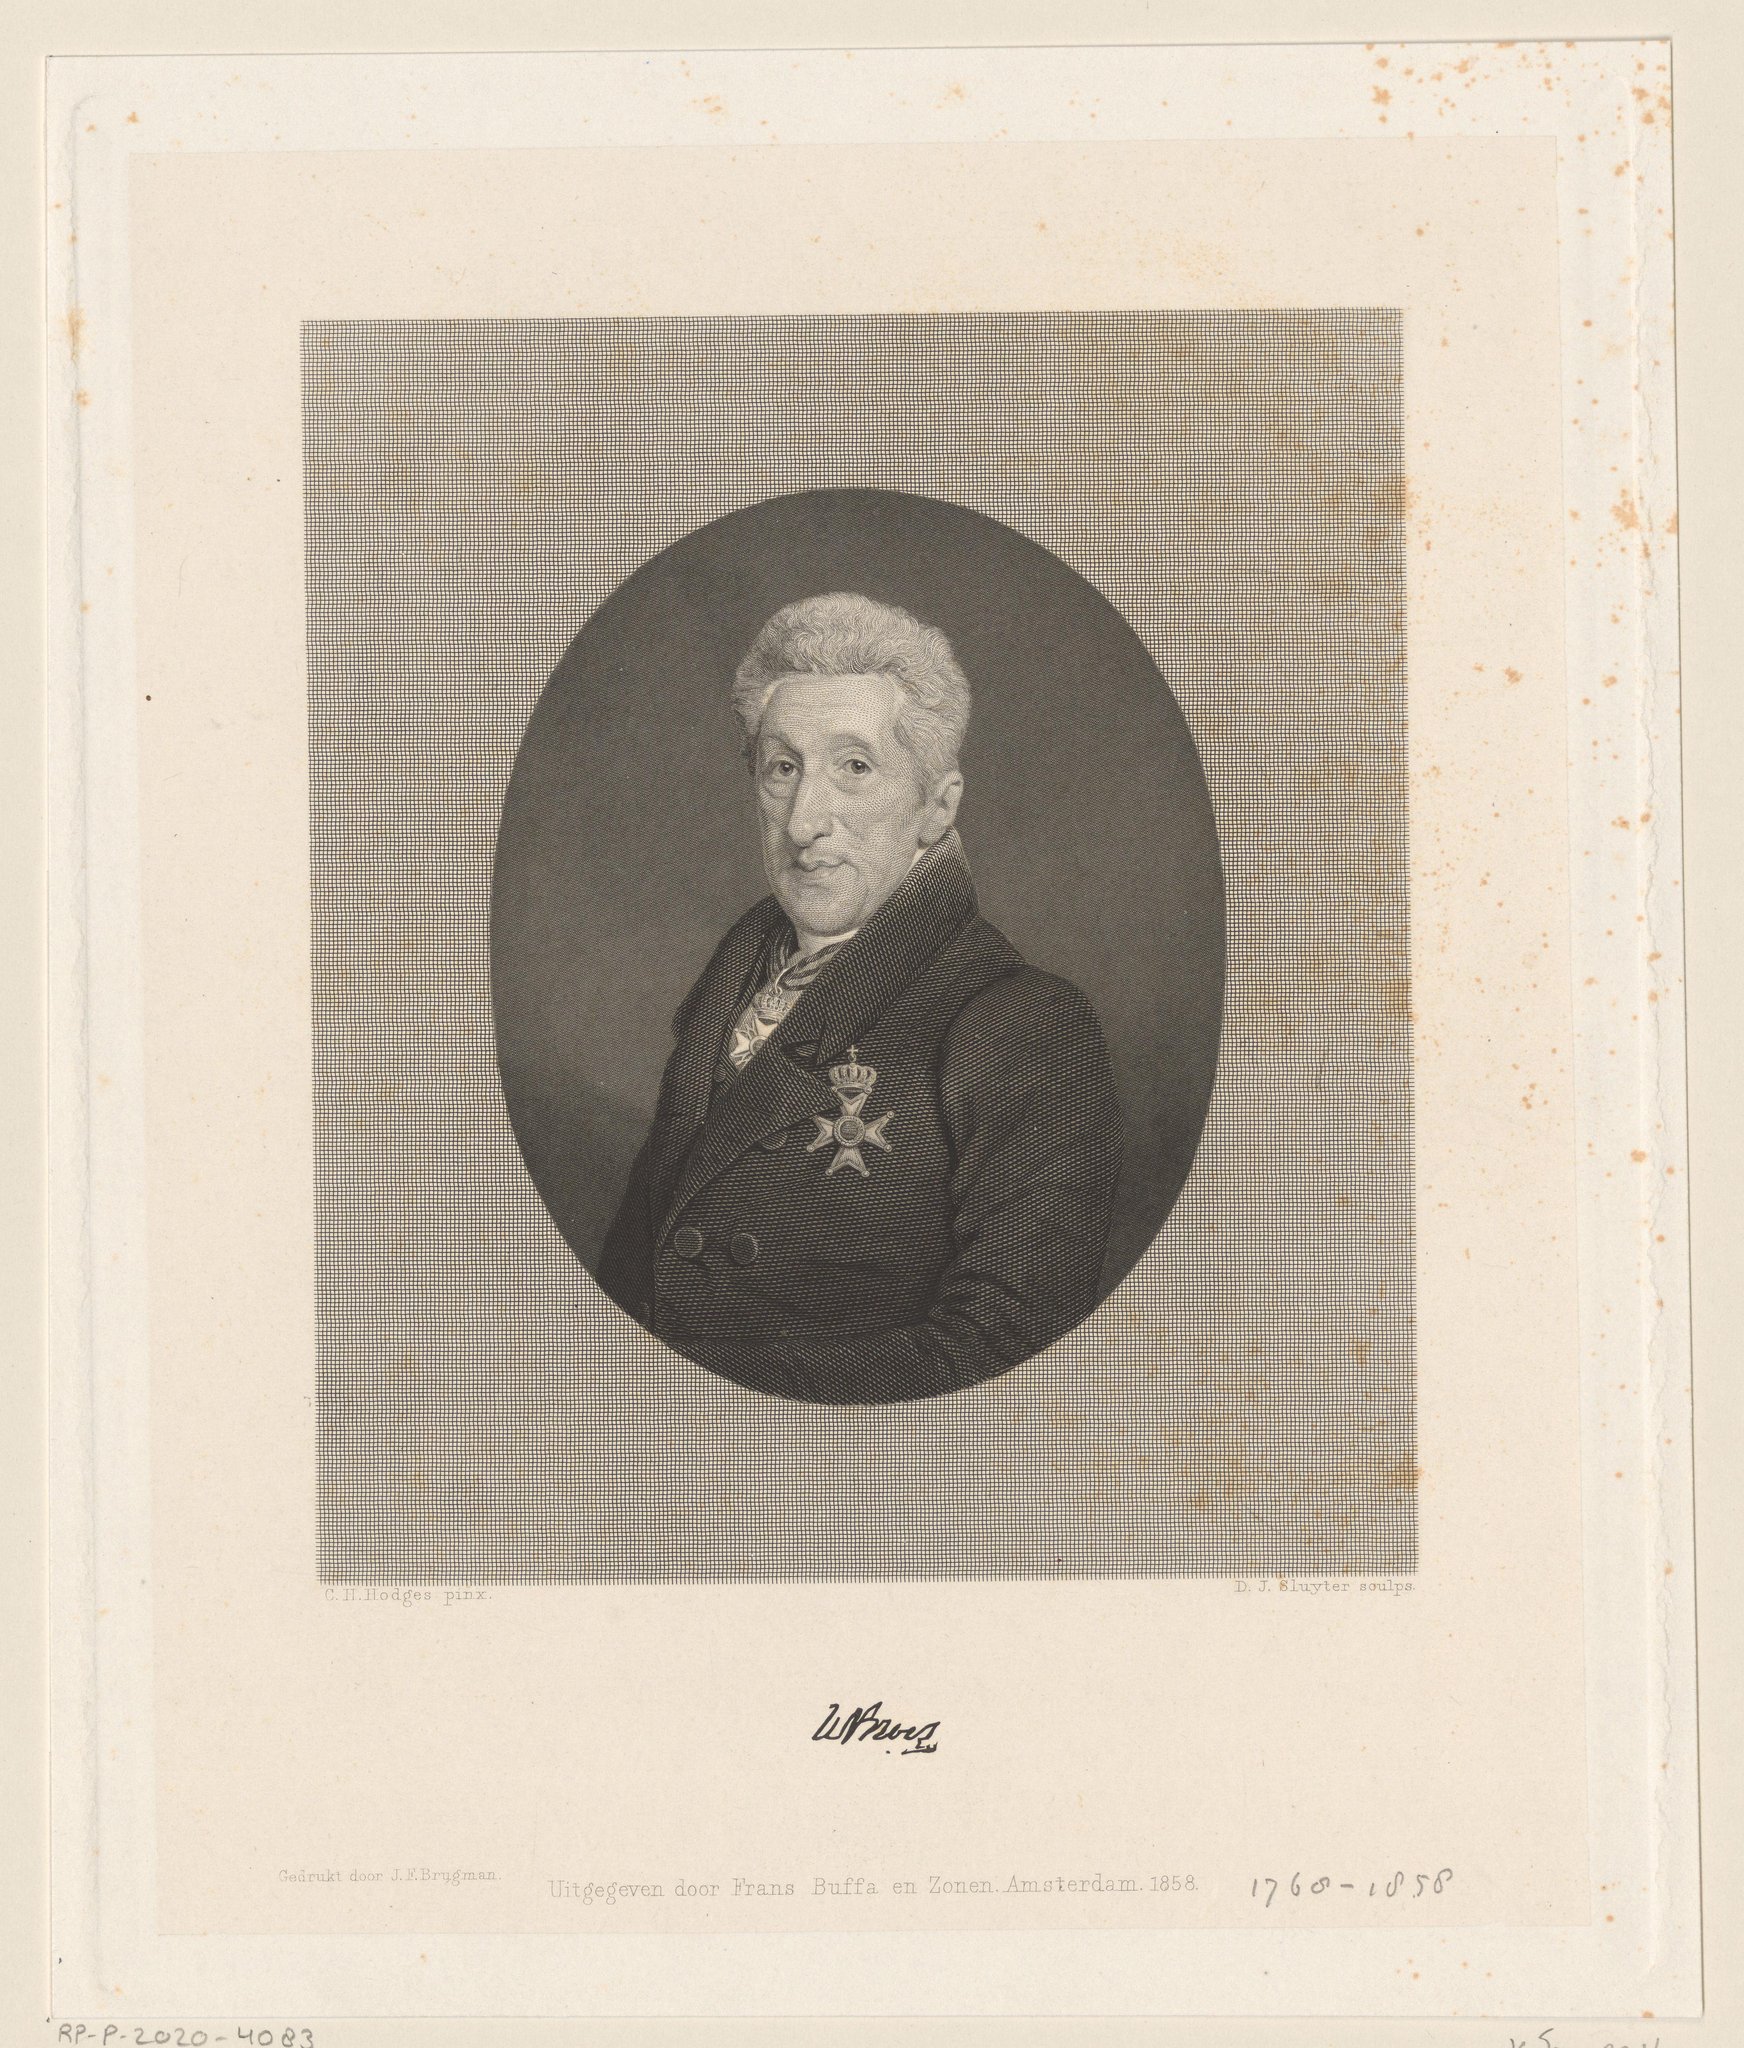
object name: print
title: Portret van Wilhelm Broes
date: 1858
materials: paper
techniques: etching, engraving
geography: amsterdam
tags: amsterdam, historical persons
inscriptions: date